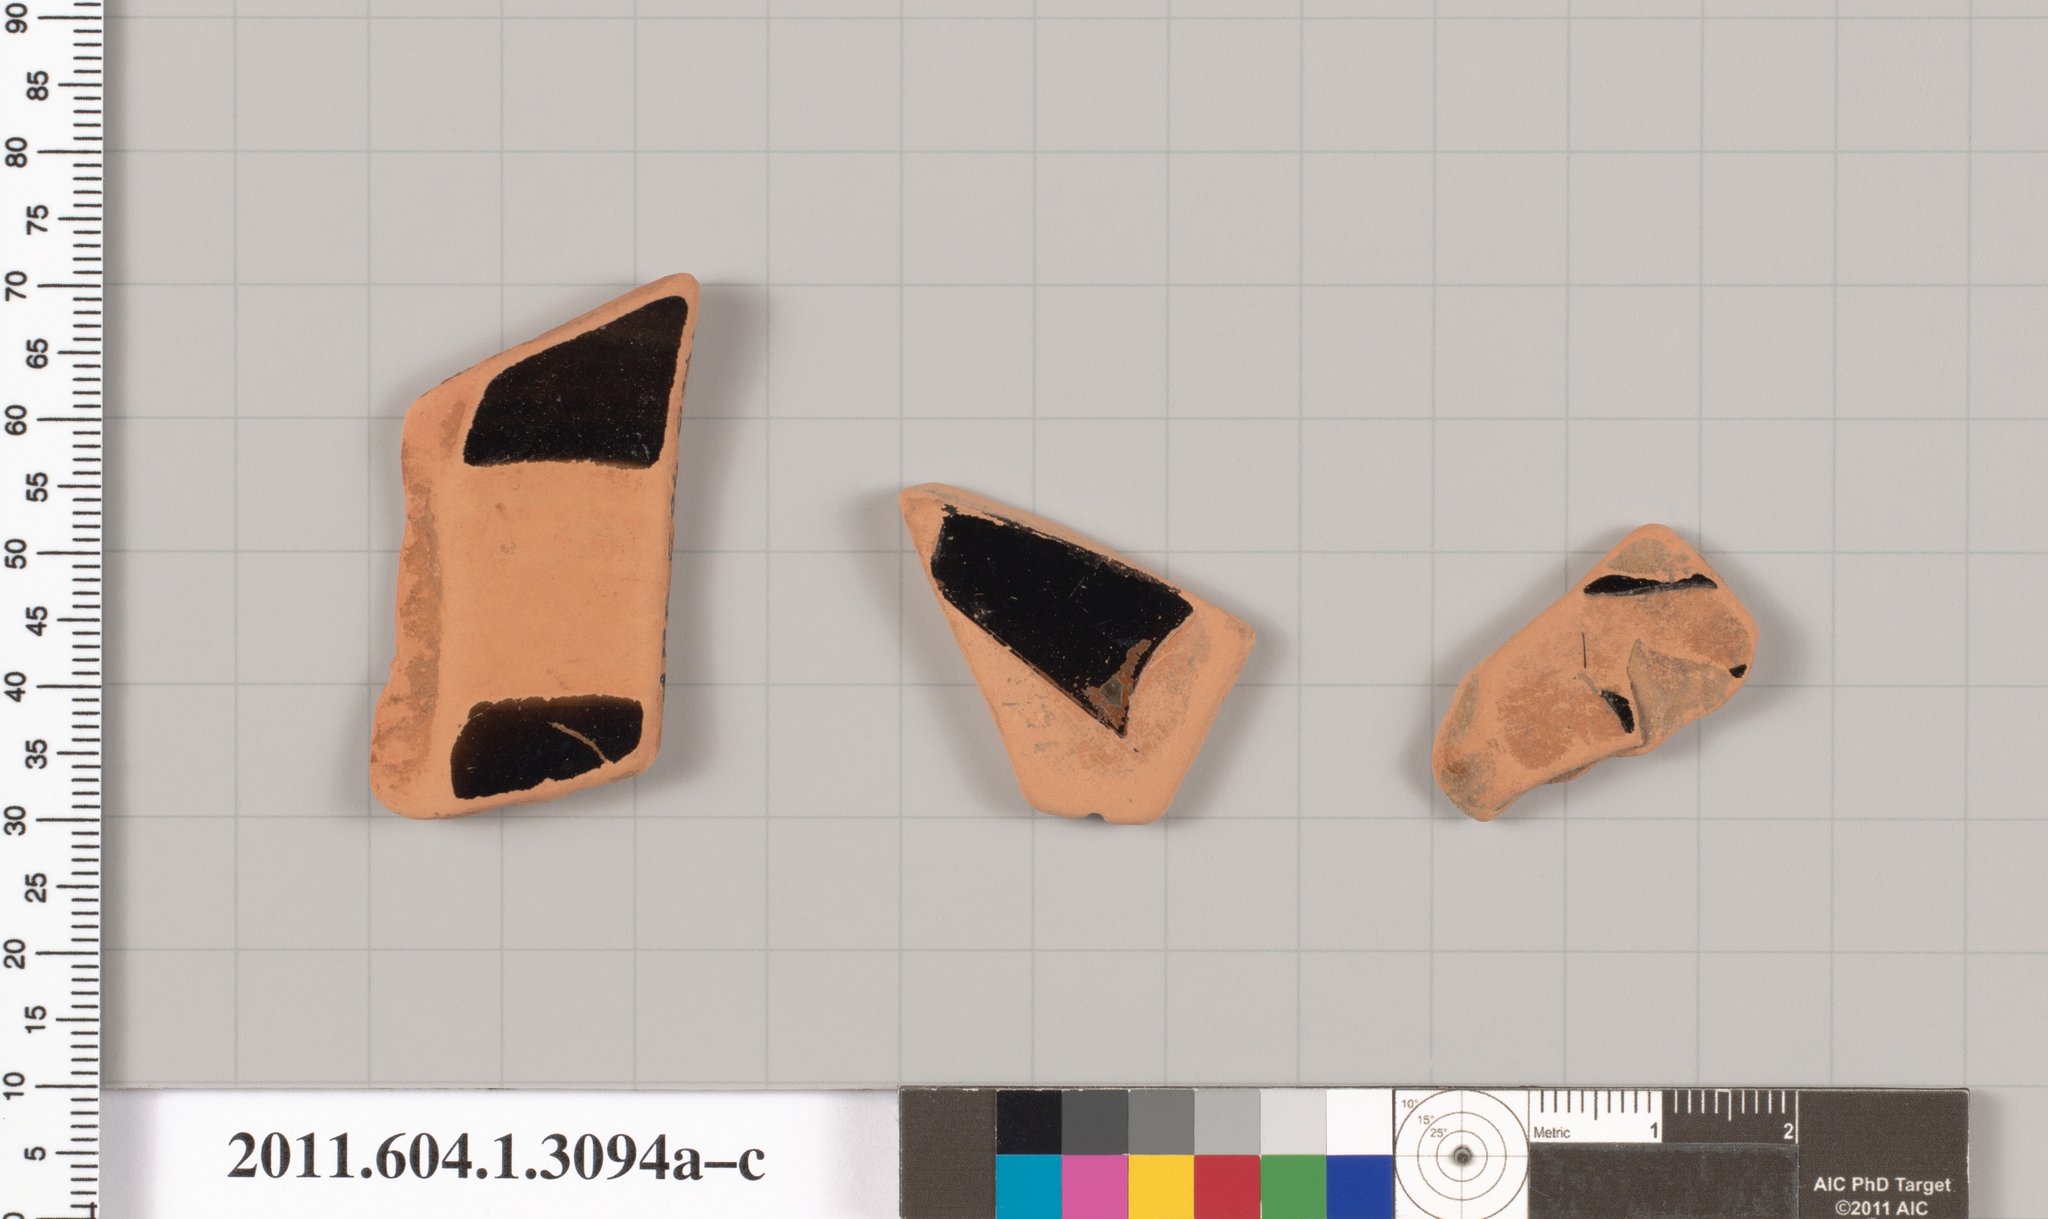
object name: kylix fragment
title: Terracotta fragments of kylikes (drinking cups)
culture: greek, attic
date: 600-401 BCE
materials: terracotta